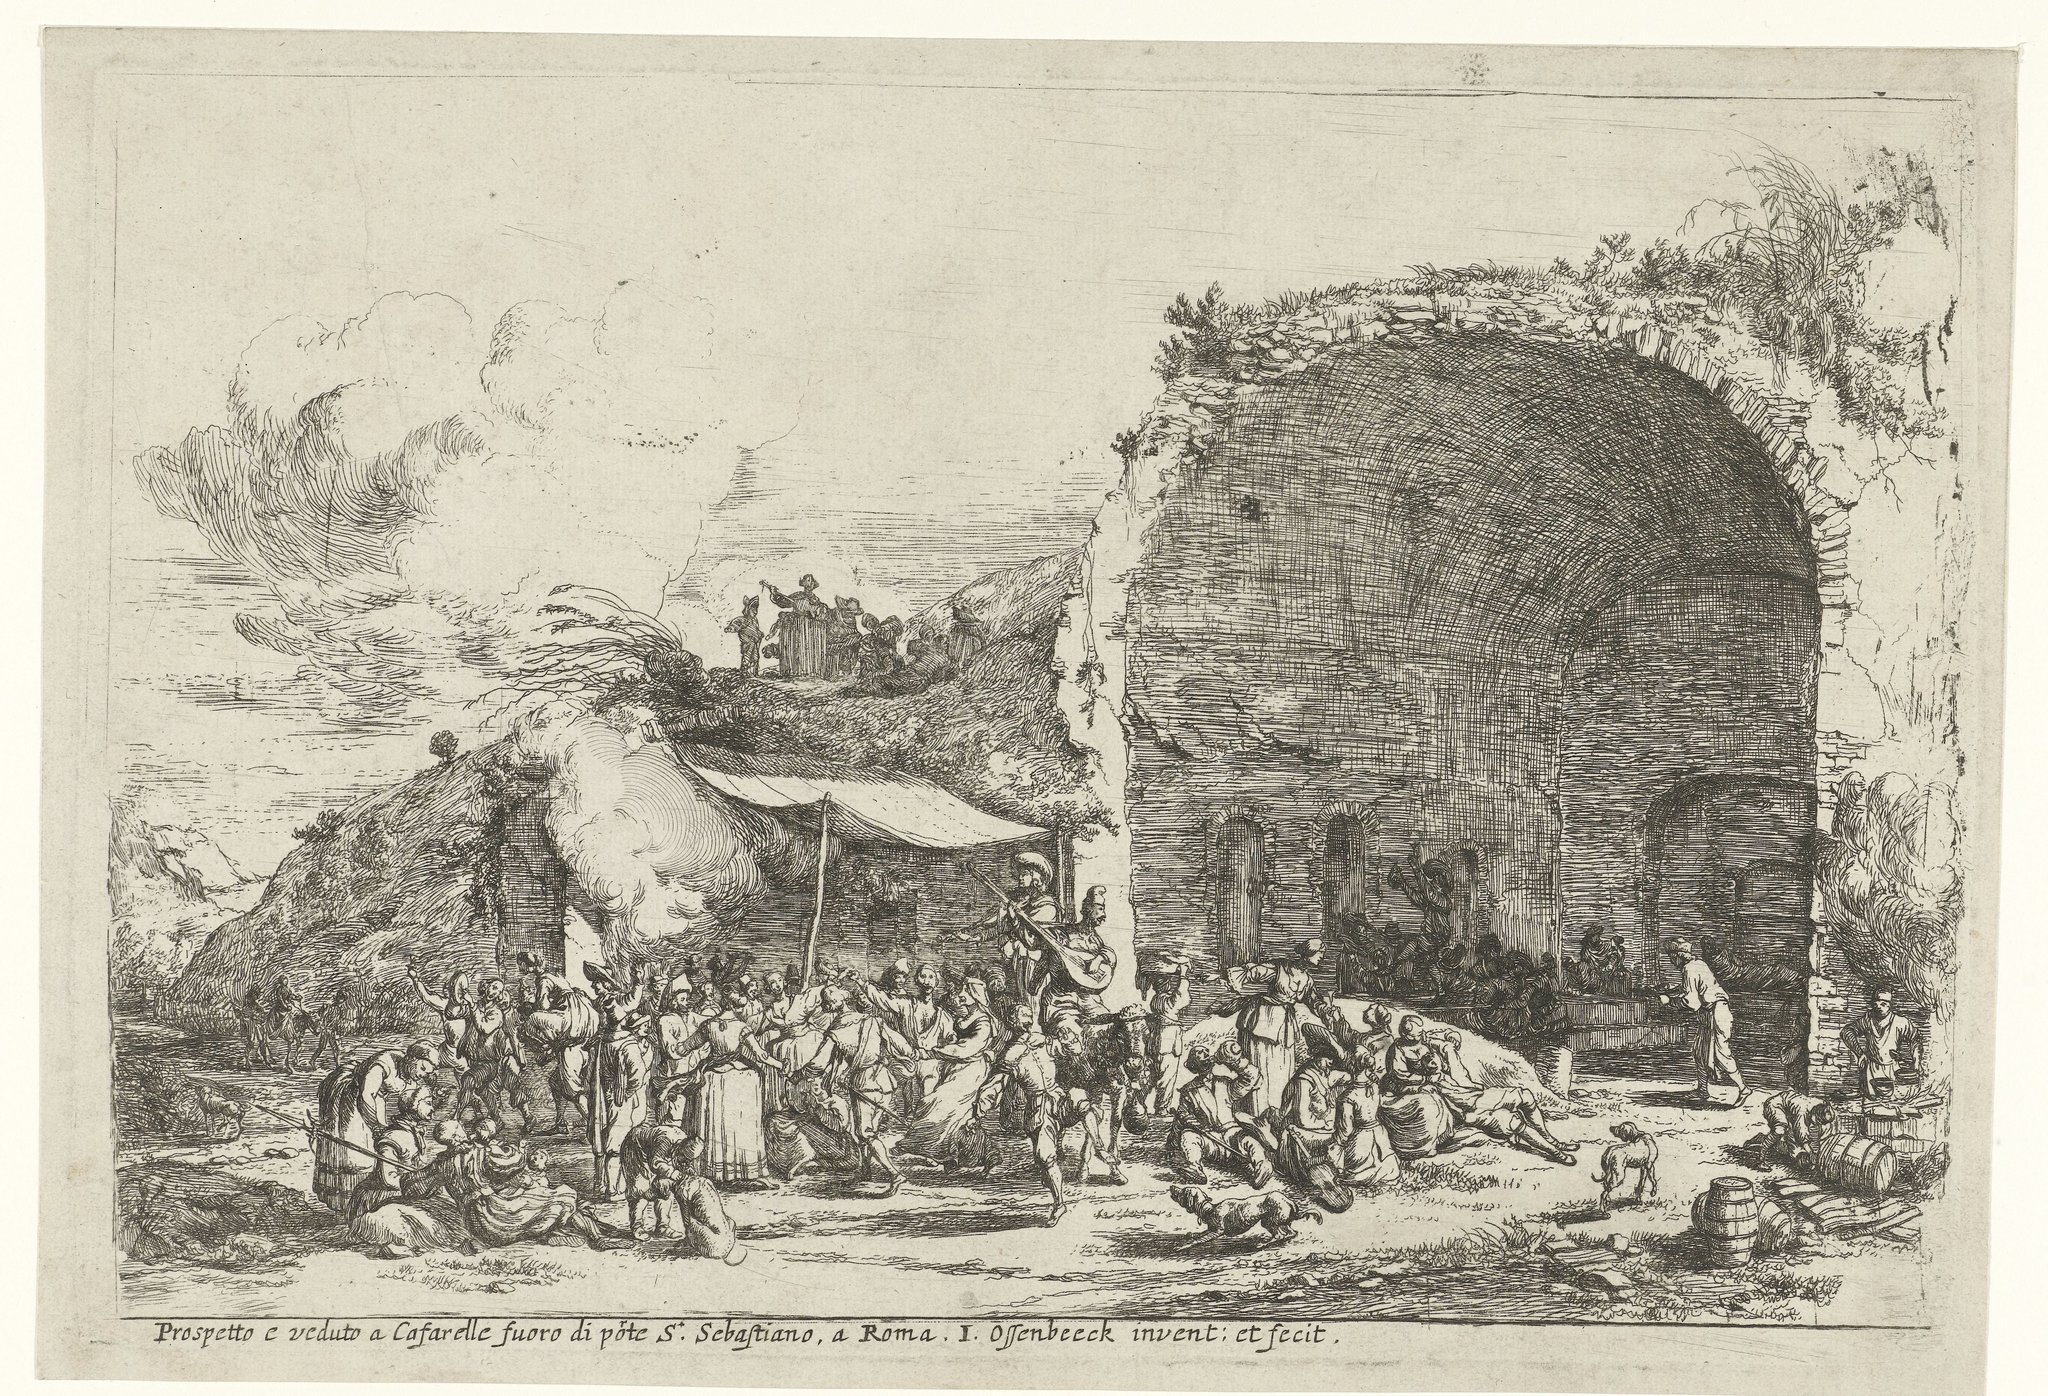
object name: print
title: Prospetto e veduto a Cafarelle fuoro di porte S. Sebastiano, a Roma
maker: jan van ossenbeeck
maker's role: print maker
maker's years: 1623-1674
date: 1647-1655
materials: paper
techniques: etching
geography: rome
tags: festivities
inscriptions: collector's mark: Lugt 2228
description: Voor en in de ruïnes van de grot van de nimf Egeria vindt een feest plaats. Er is met een doek en een stok een afdakje gemaakt. Mensen maken muziek, dansen, eten en drinken. Onder het resterende tongewelf zijn tafels met stoelen opgesteld.